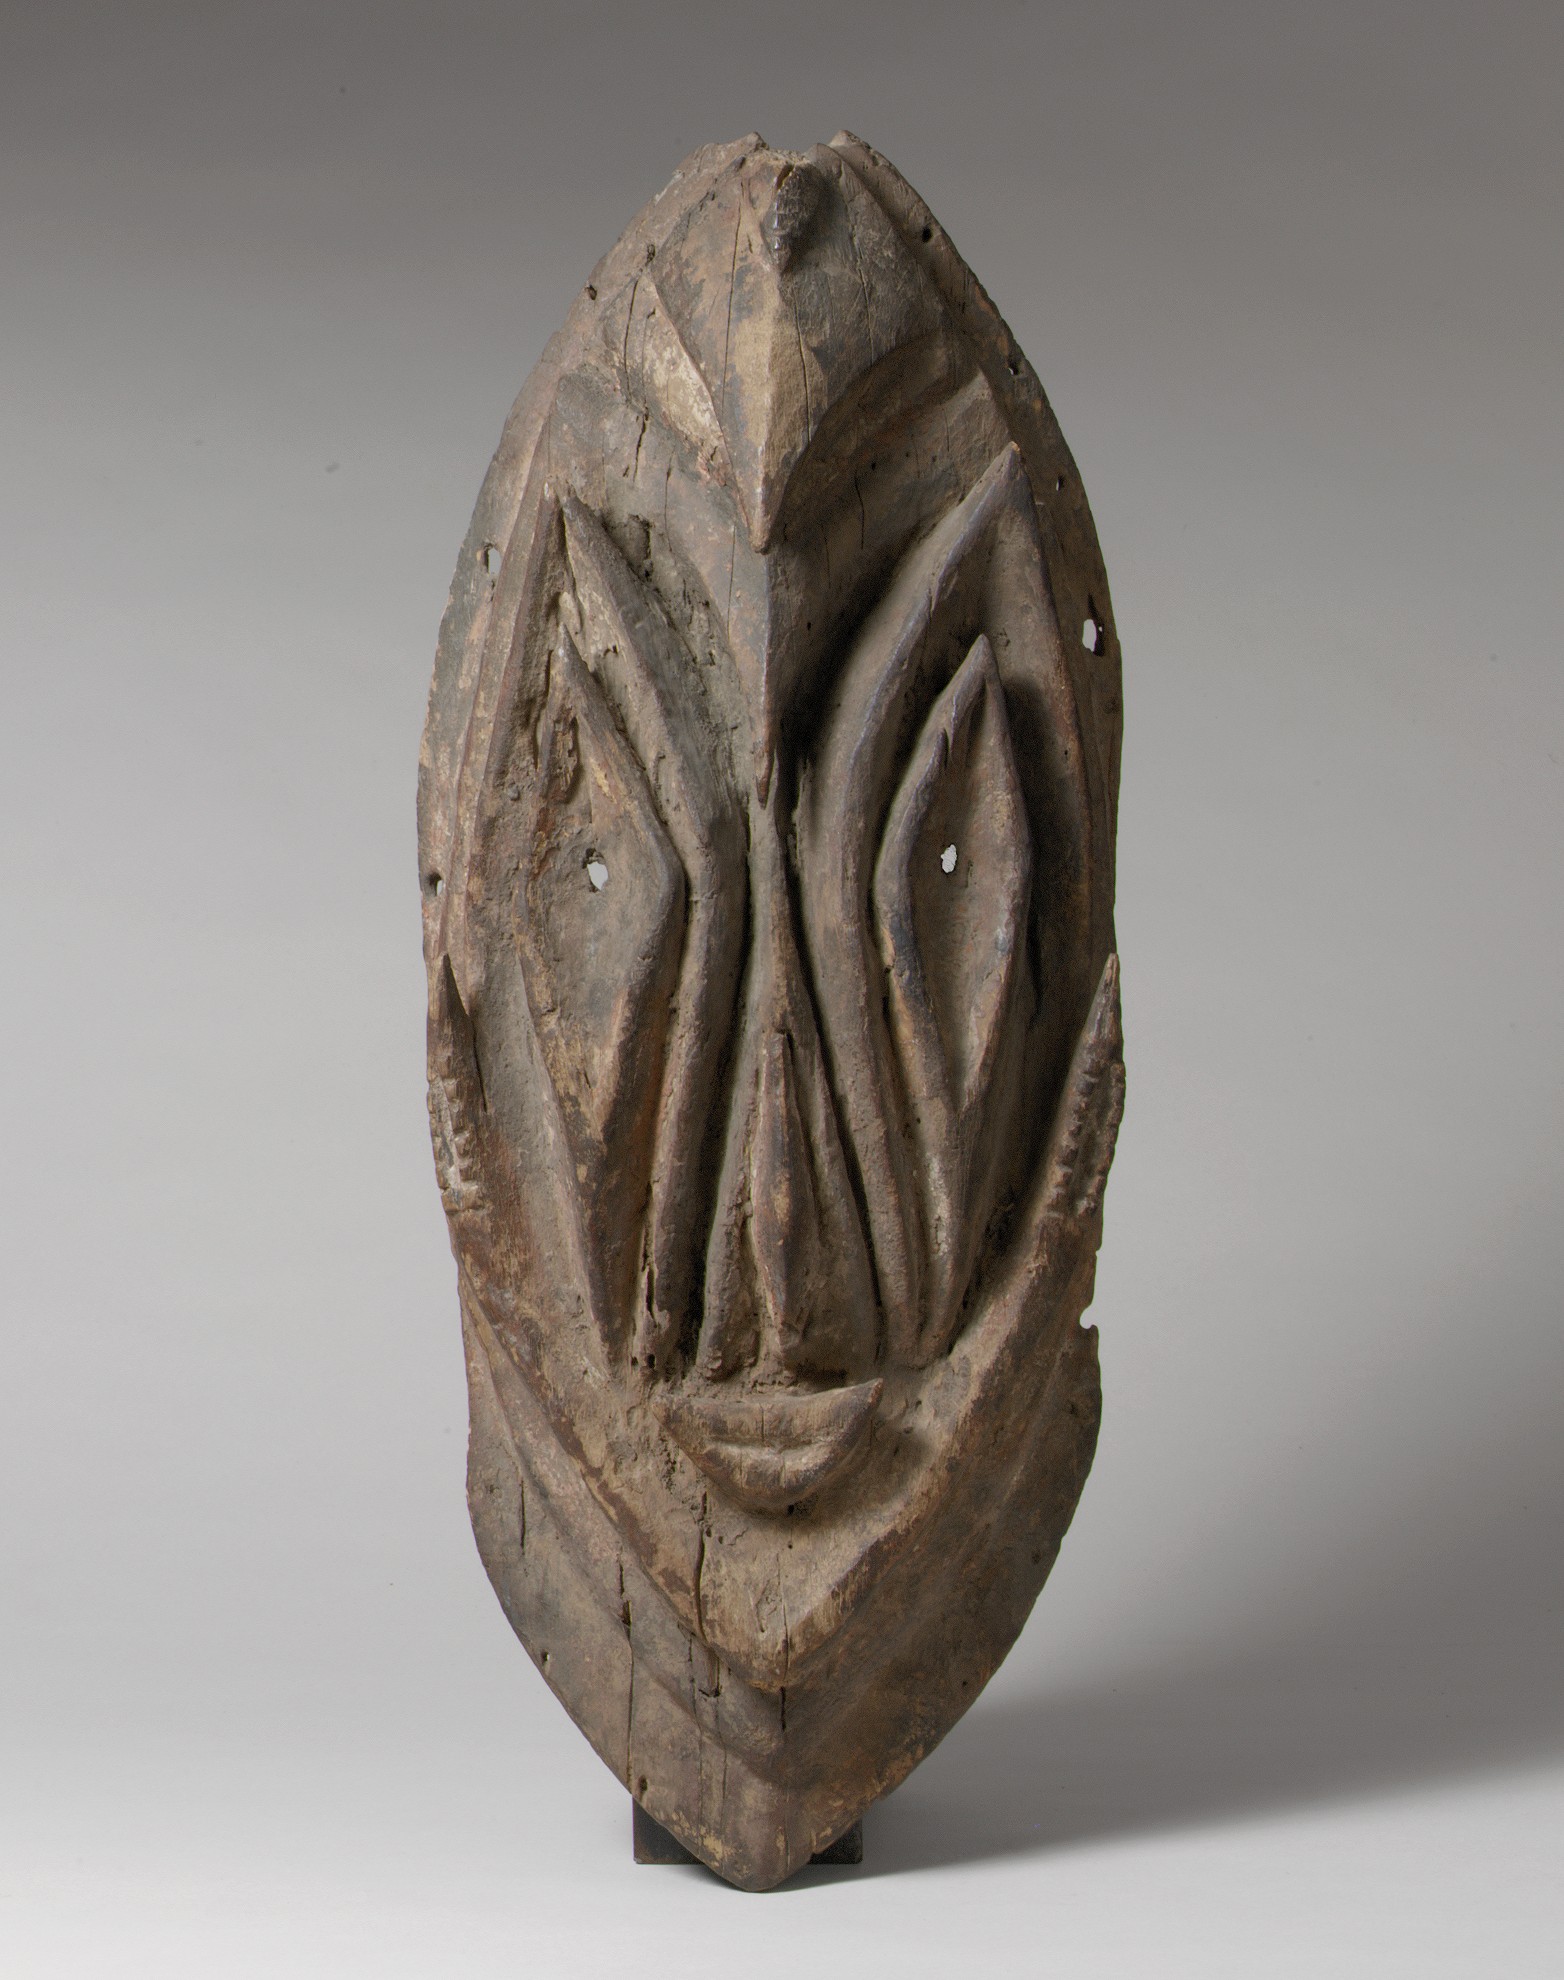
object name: mask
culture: romkun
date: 1801-1900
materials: wood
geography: papua new guinea